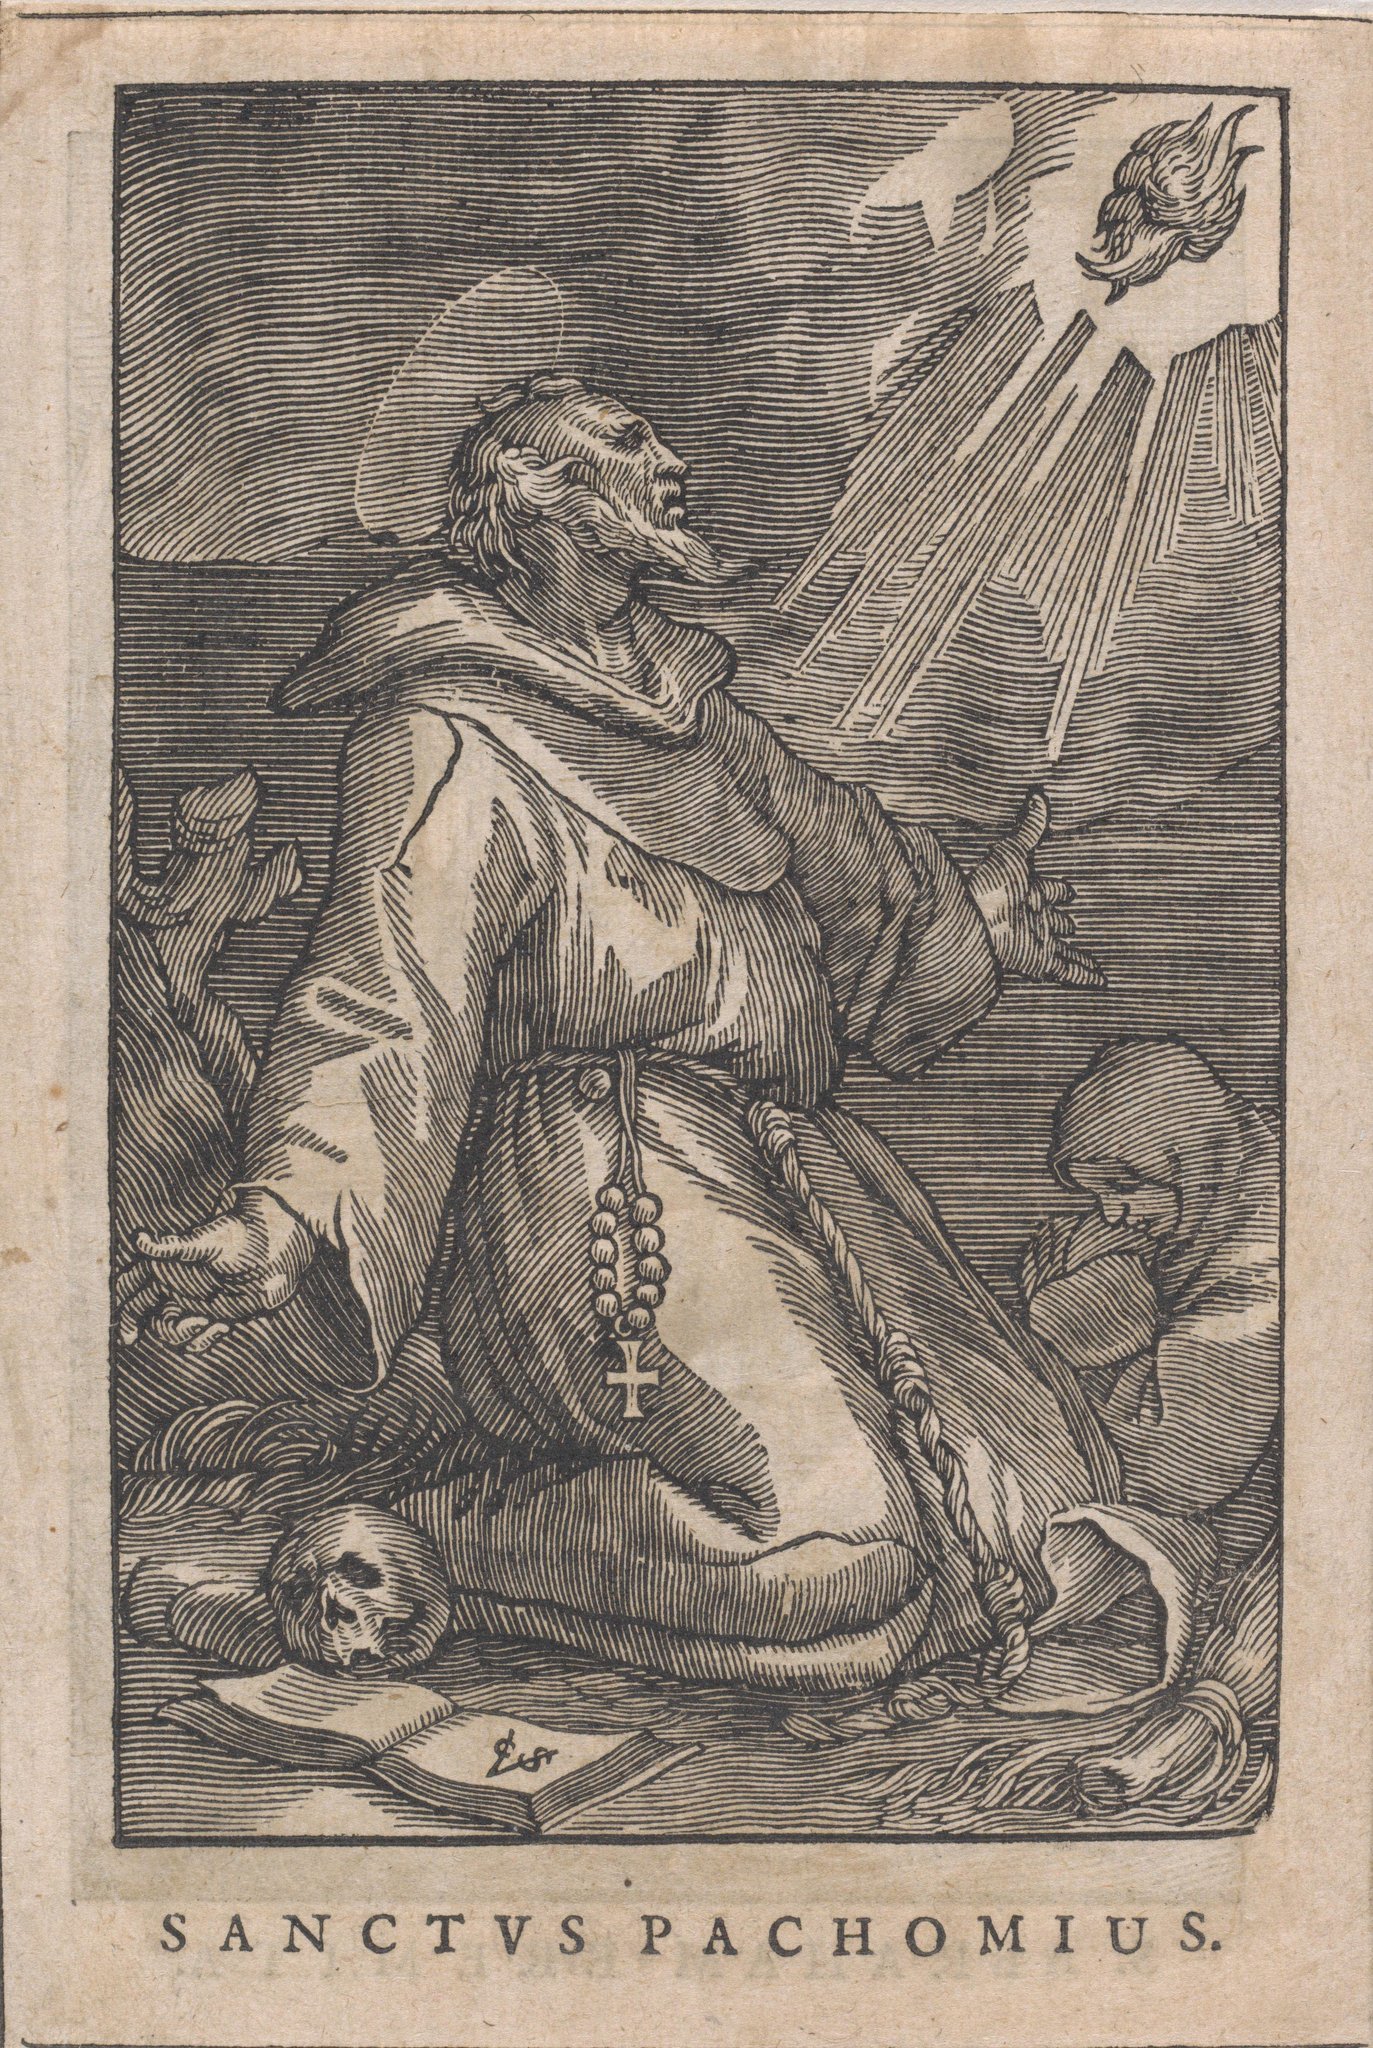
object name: book illustration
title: Sanctus Pachomius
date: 1644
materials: paper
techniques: letterpress printing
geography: amsterdam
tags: saints, anchorite, hermit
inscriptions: collector's mark: Lugt 2228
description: Prent uit: Rosweyde, Heribert. 'tBosch der eremyten ende eremitinnen, van Aegypten ende Palestinen. Amsterdam: Pieter Jacobsz. Paets, 1644.